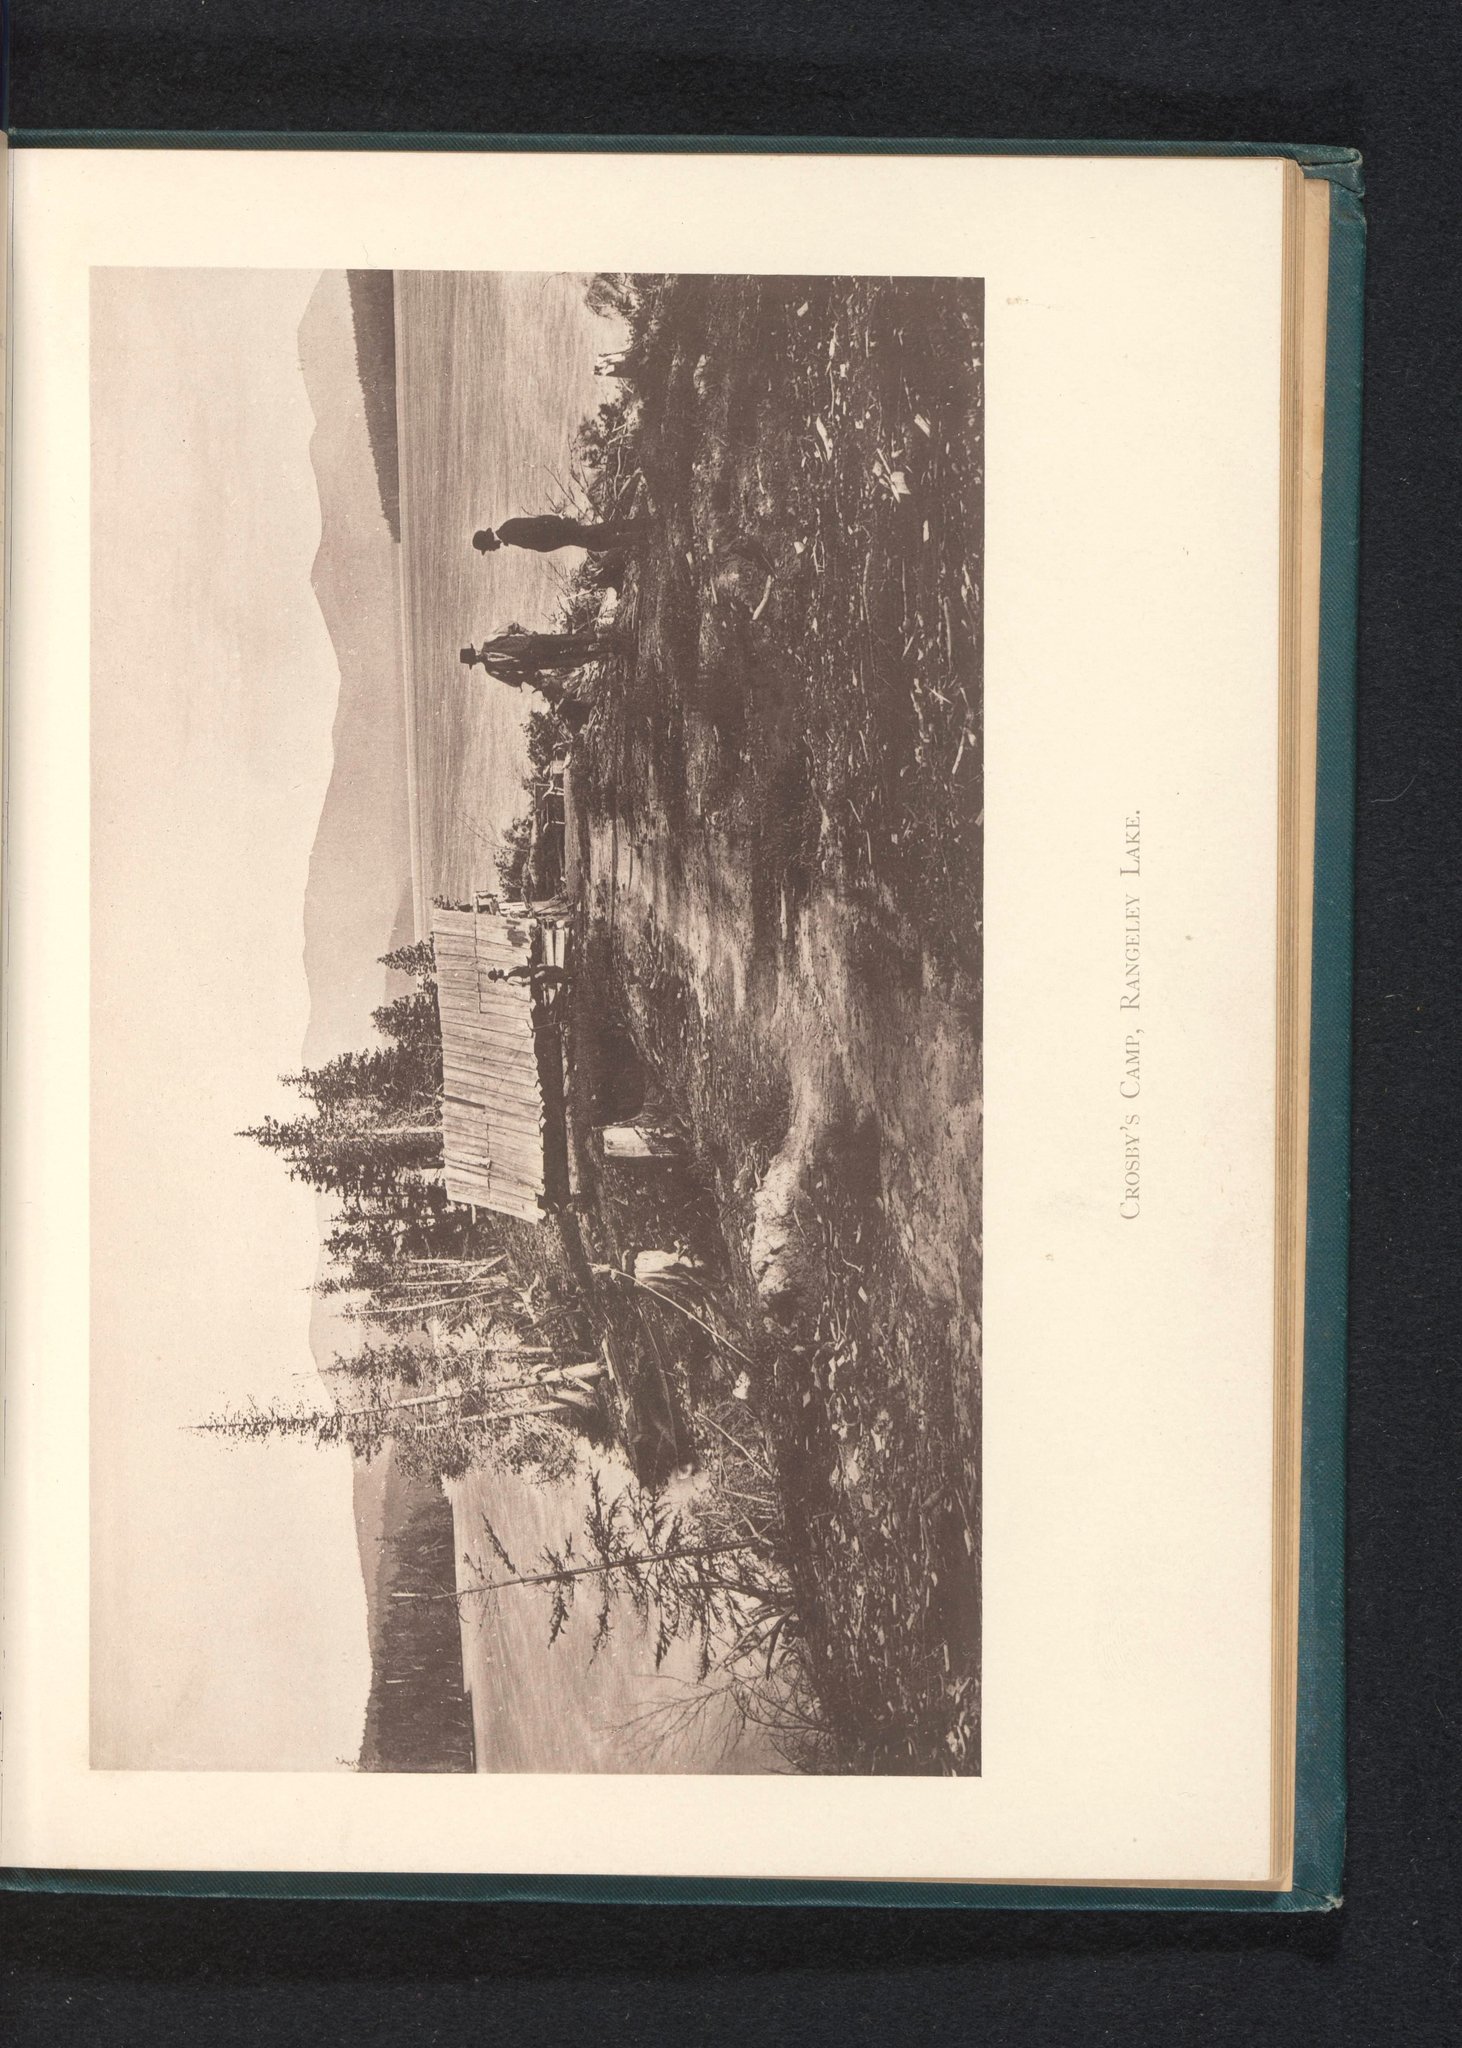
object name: photomechanical print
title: Crosby's Camp, Rangeley Lake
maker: Anonymous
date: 1875-1880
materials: paper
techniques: photograph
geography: rangeley lake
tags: adult man, lake, hut, cabin, lodge